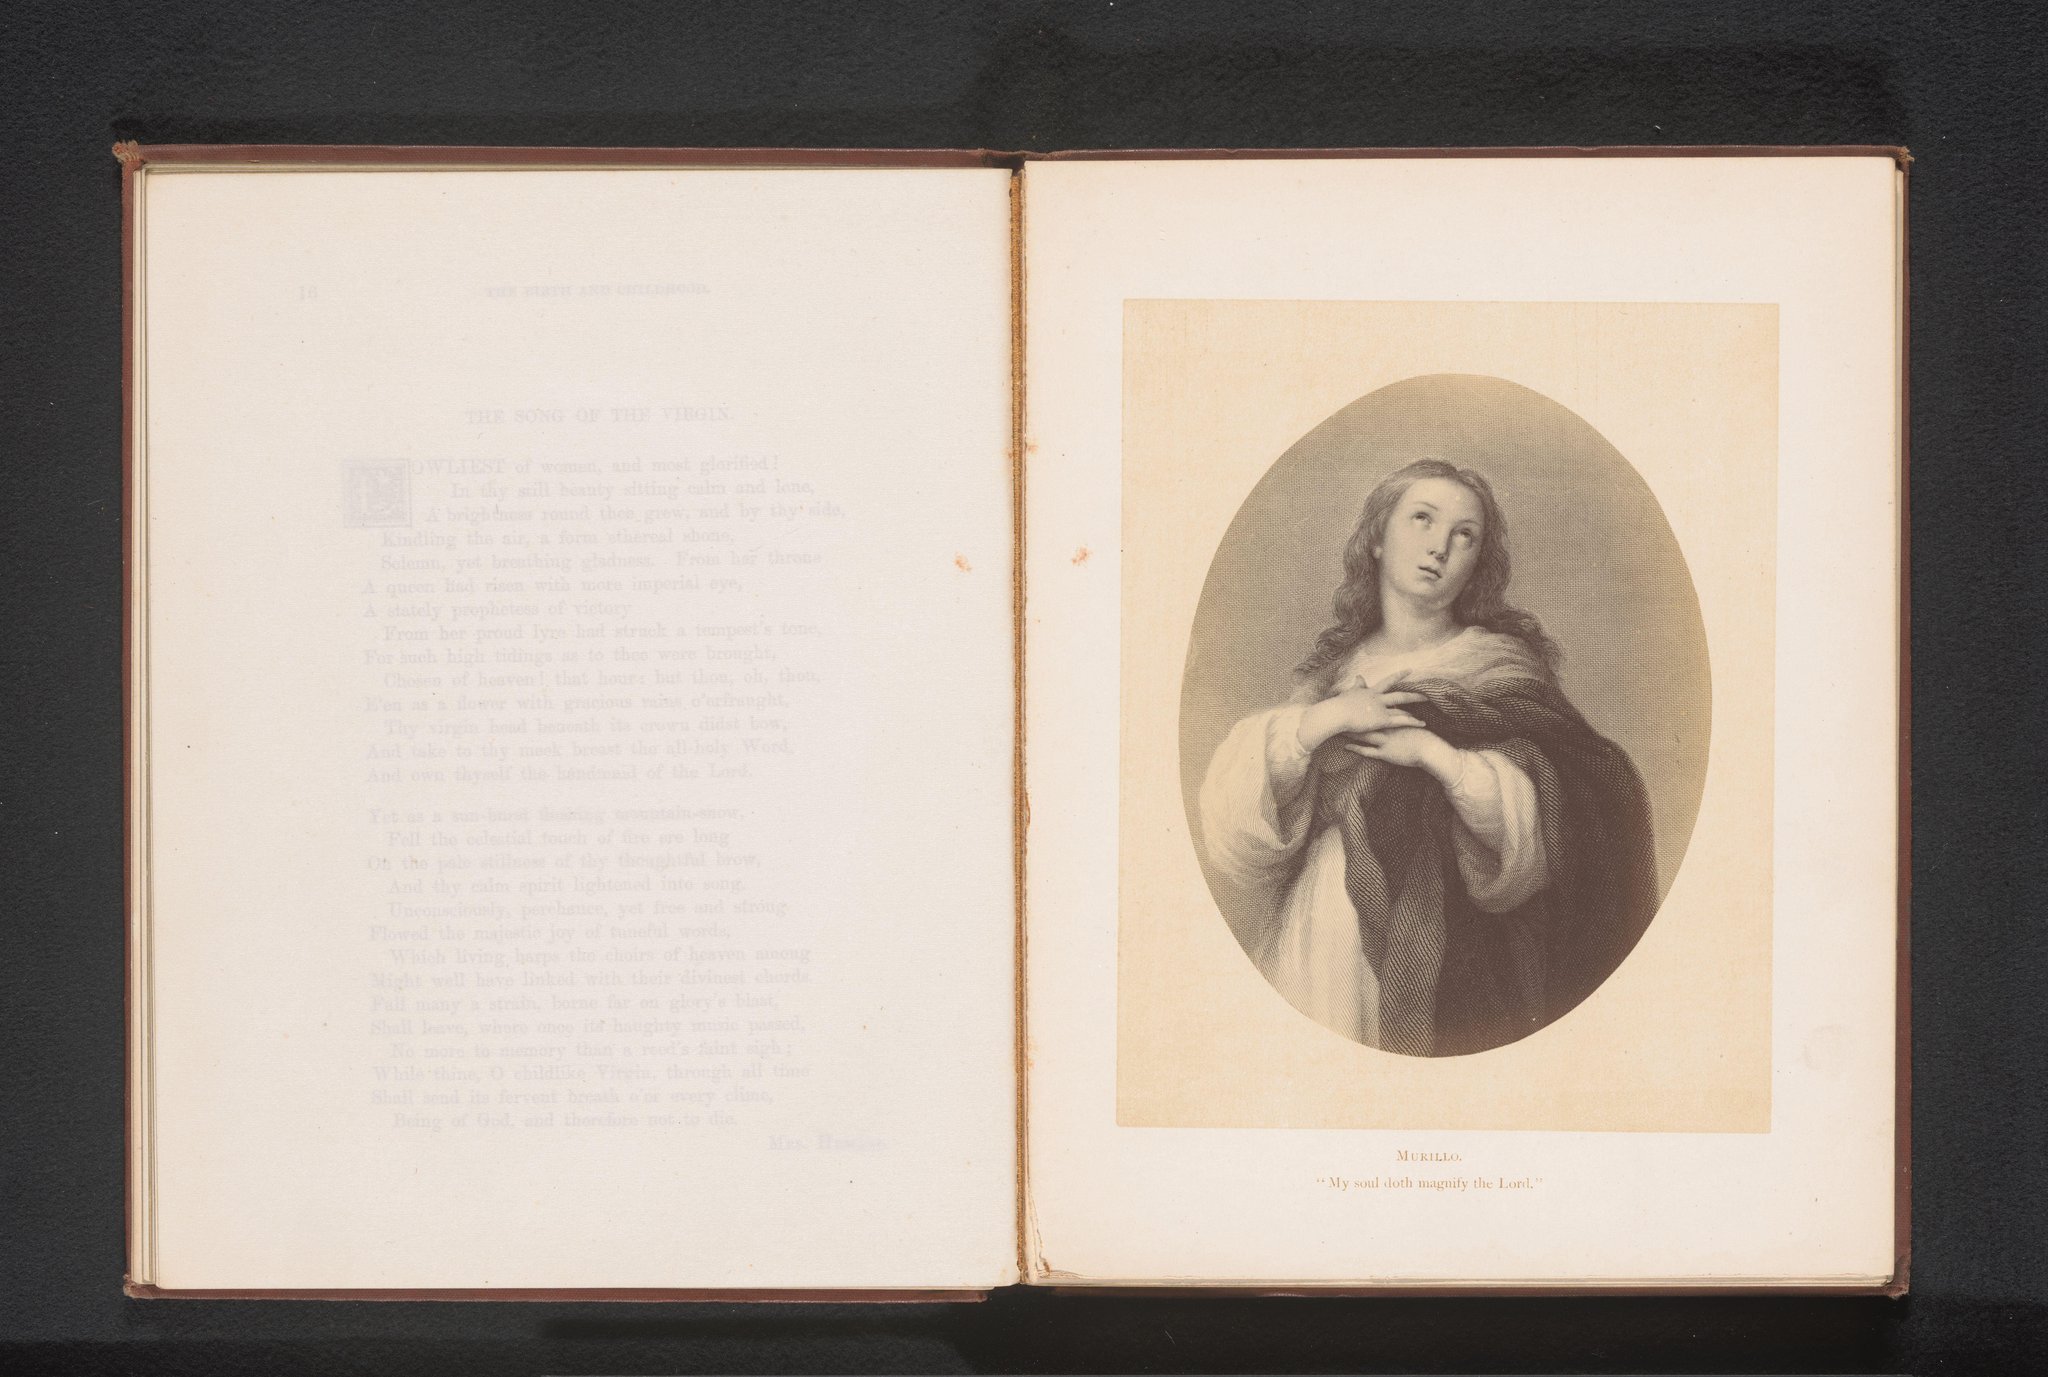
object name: page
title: Fotoreproductie van een prent naar een schilderij, voorstellende de lofzang van Maria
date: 1861-1871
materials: photographic support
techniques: albumen print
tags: mary magnifying the lord ('magnificat')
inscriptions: inscription: ‘"My soul doth magnify the Lord."’